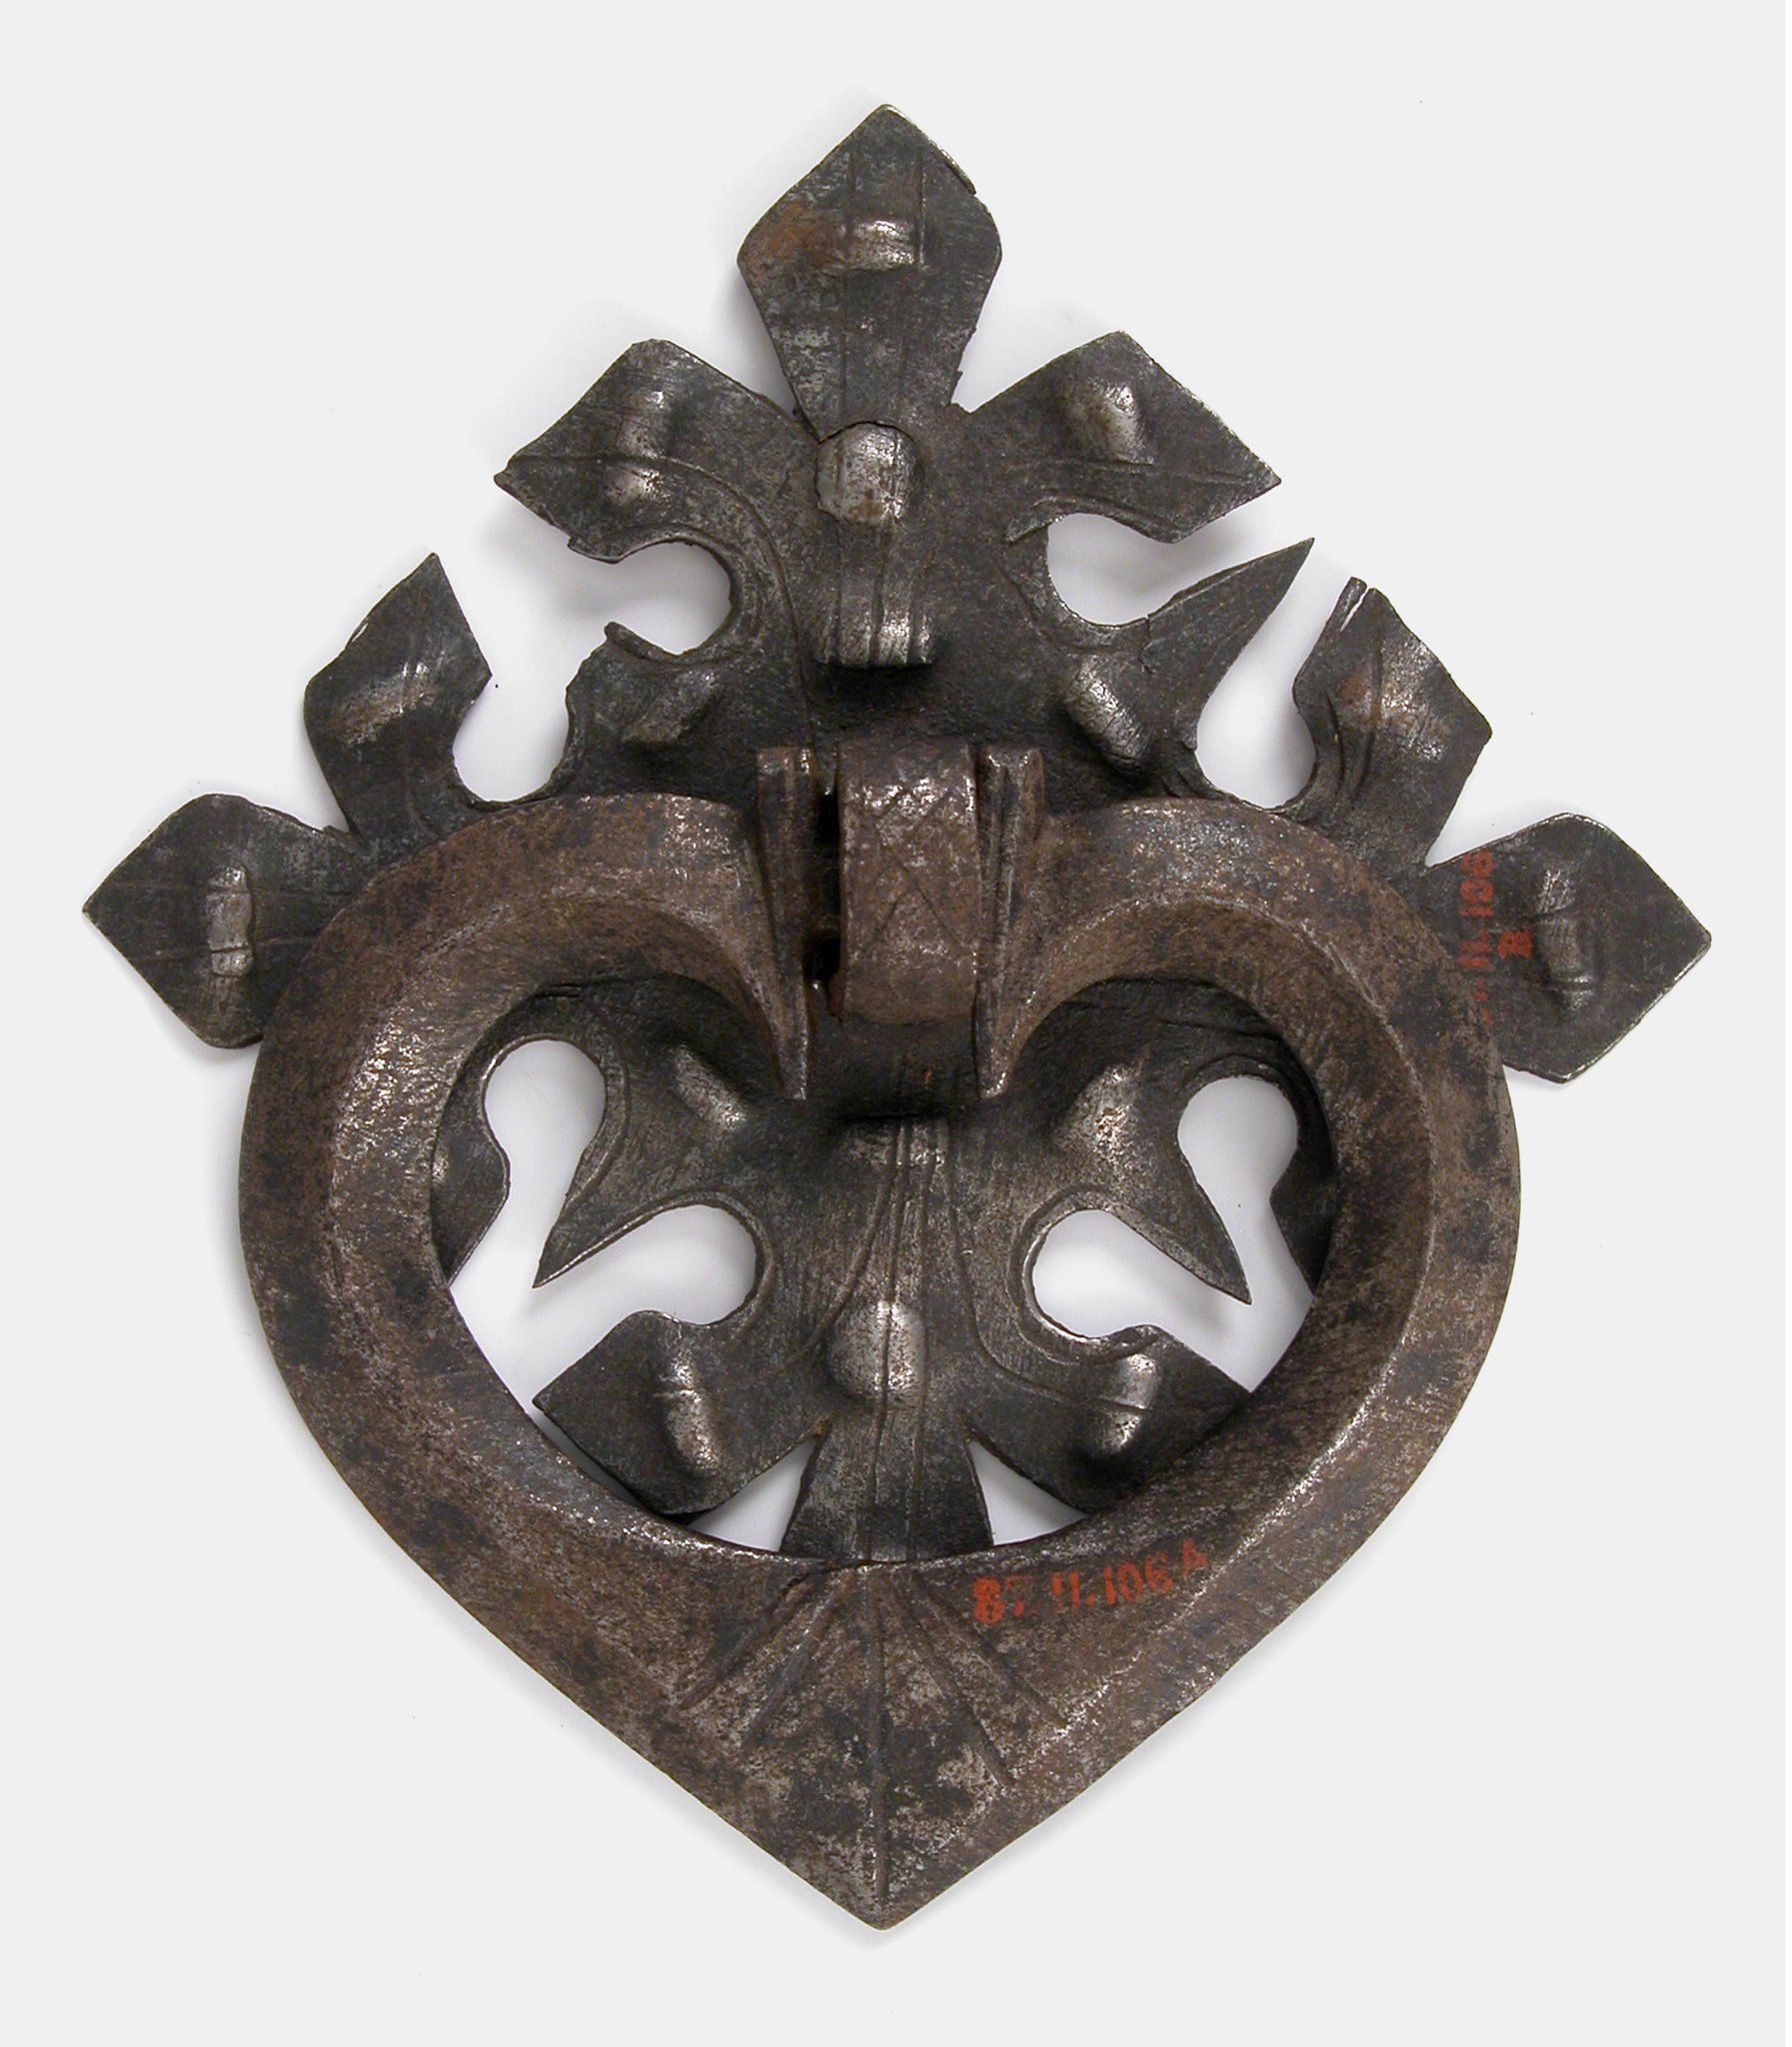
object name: door handle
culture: german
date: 1467-1500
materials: iron